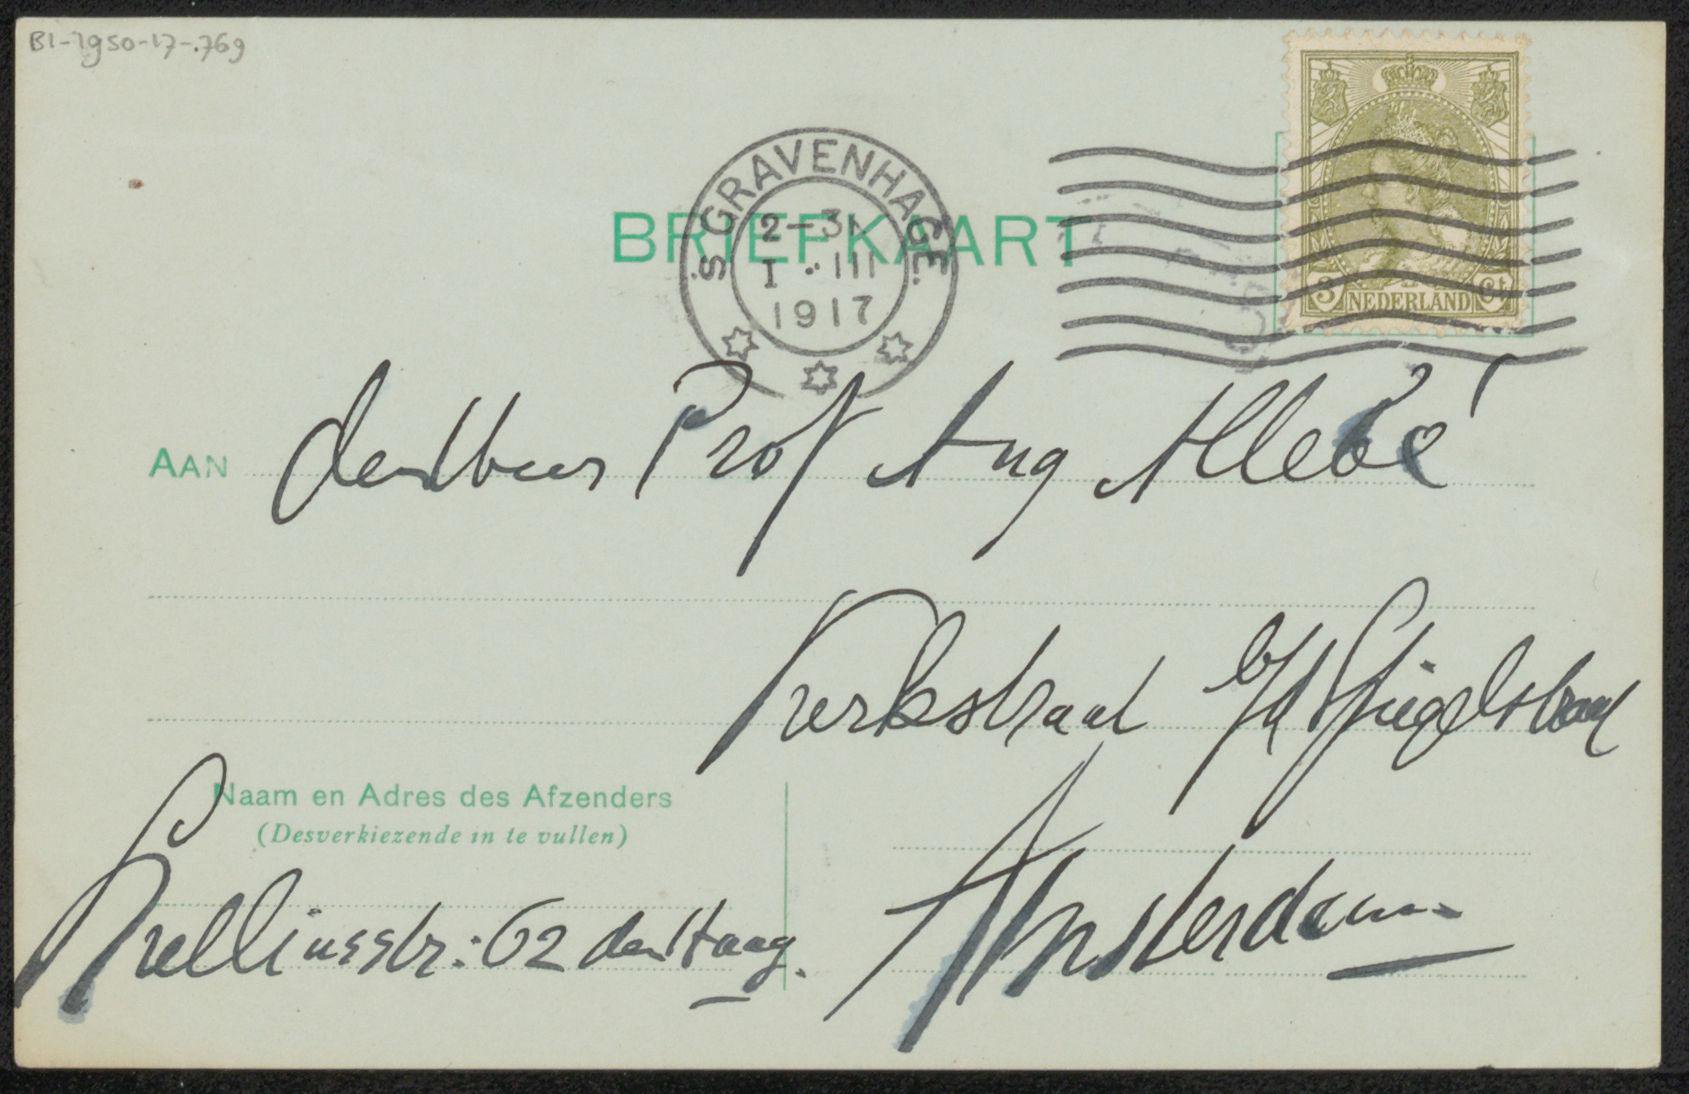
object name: postcard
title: Briefkaart aan August Allebé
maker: henri wouters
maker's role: draughtsman, print maker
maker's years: 1866-1935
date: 1917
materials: cardboard, ink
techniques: pen, writing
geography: the hague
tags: amsterdam, print maker, draughtsman, august allebé, art trade, art shop, painting (including book-illumination, miniature-painting)